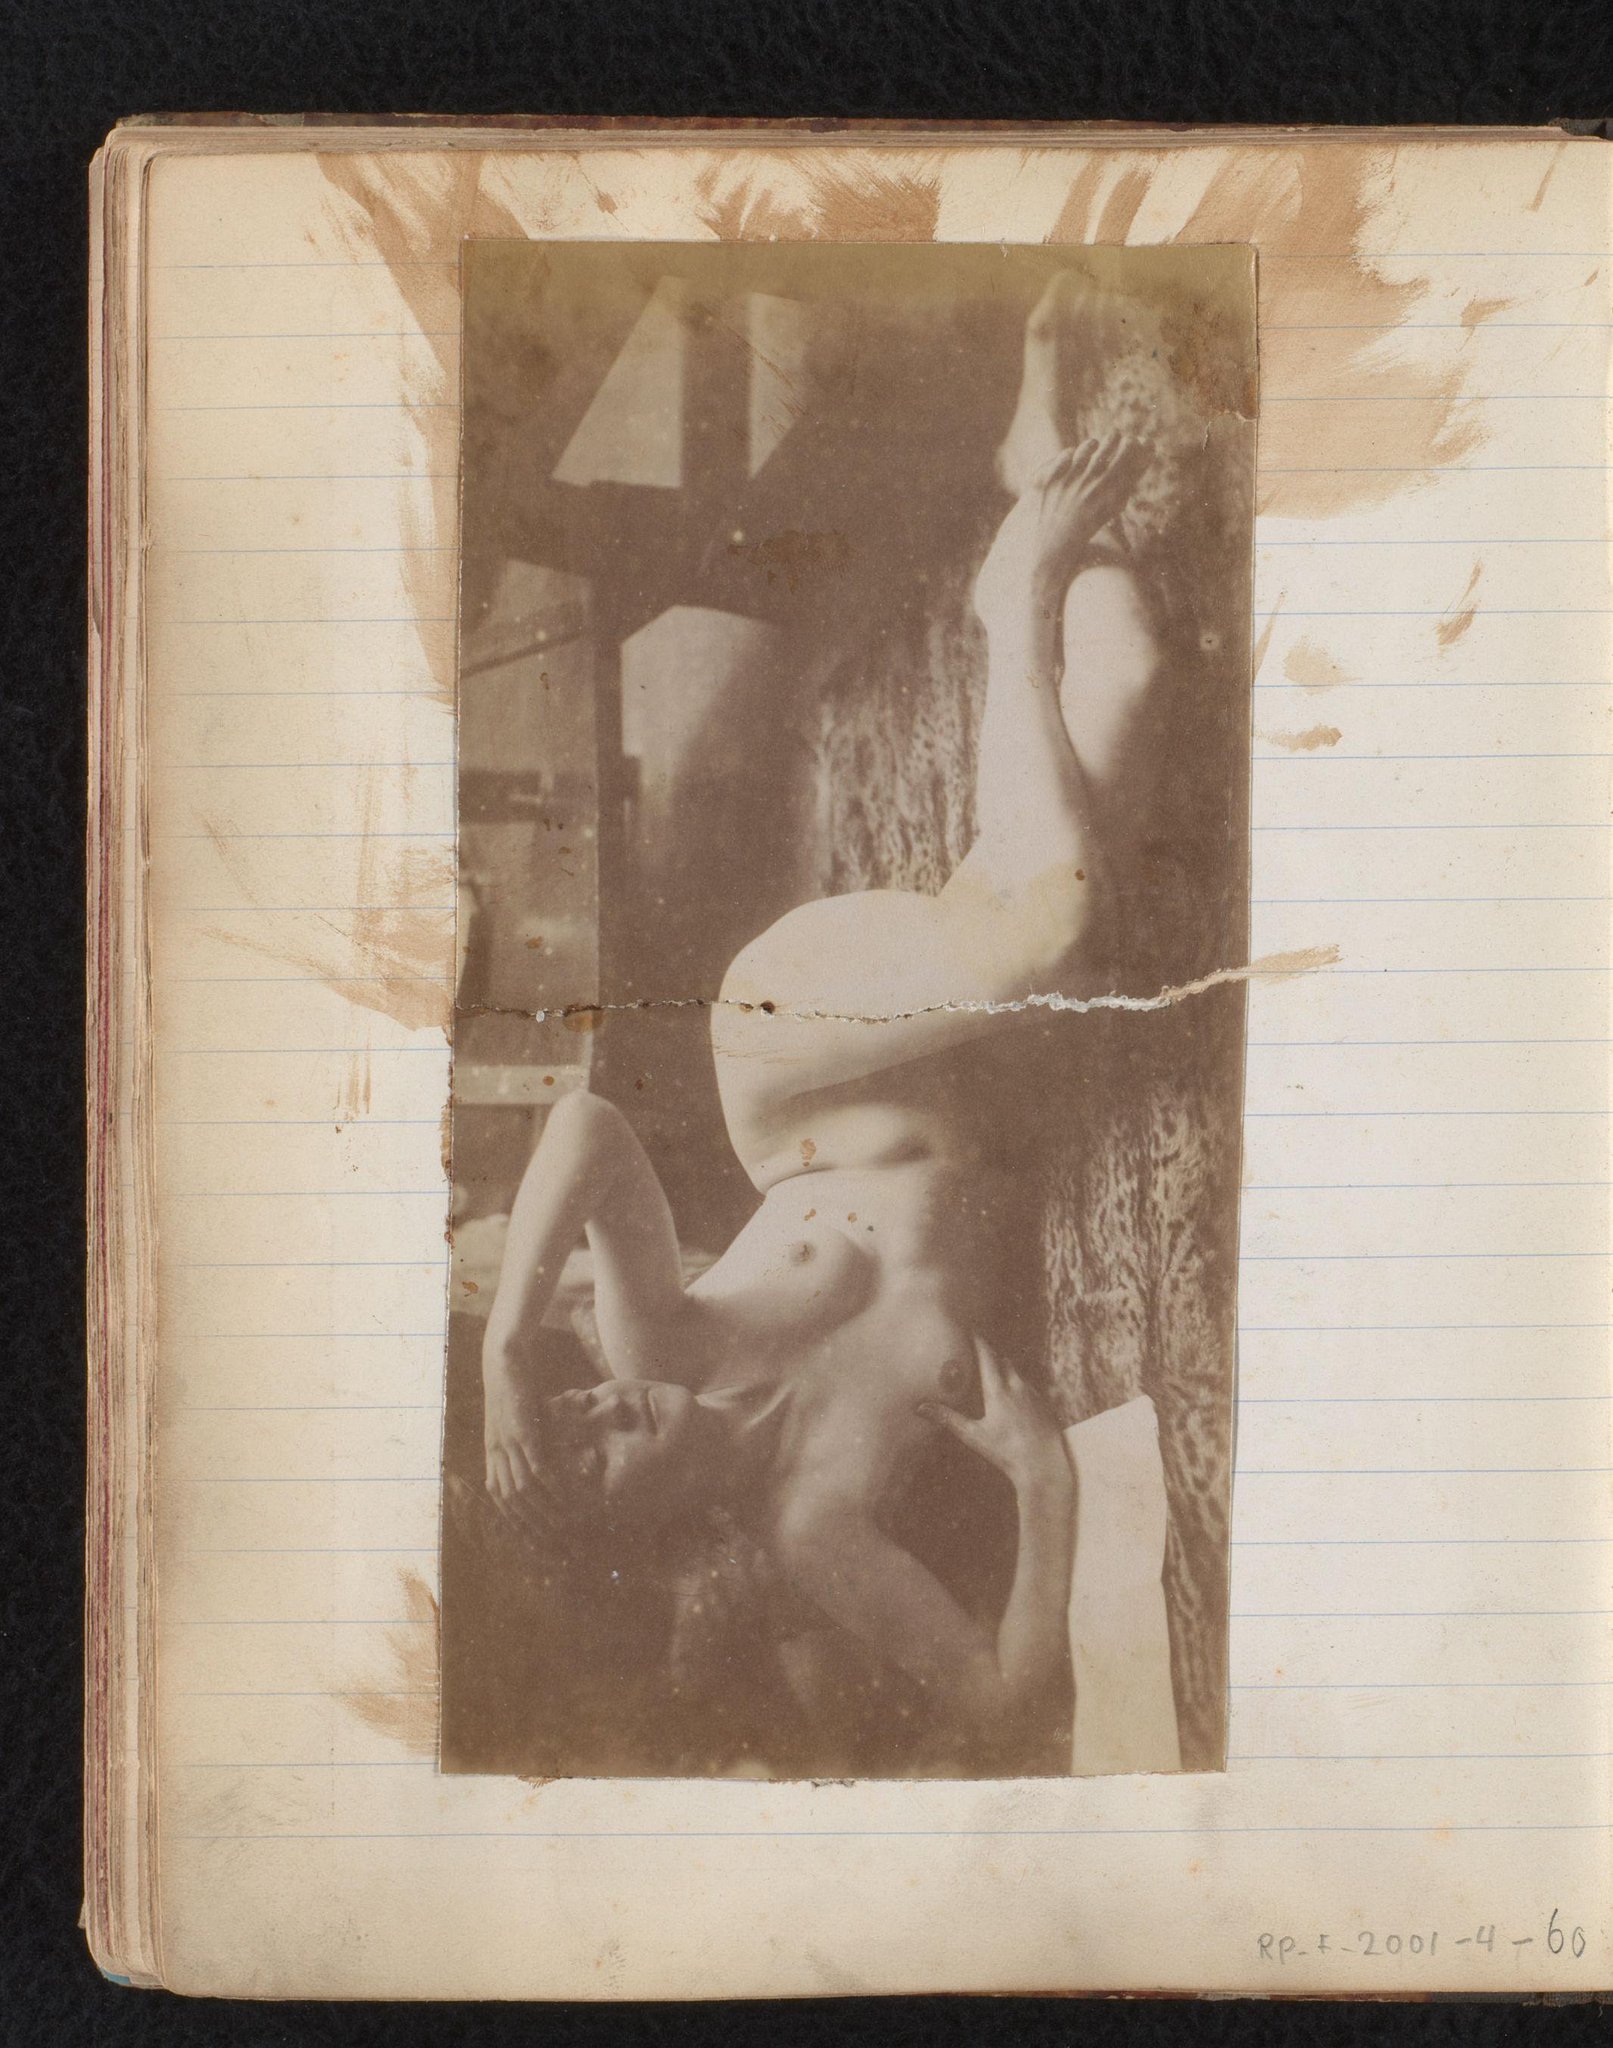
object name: album leaf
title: Studie van een vrouwelijk naaktmodel, liggend op een tijgervel, in het atelier van Jacques de Lalaing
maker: jacques lalaing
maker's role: painter, sculptor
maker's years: 1858-1917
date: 1883-1914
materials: photographic support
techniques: albumen print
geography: brussels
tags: adult woman, the (nude) human figure; 'corpo humano' (ripa) (+ lying), artist (in general) working from nude model